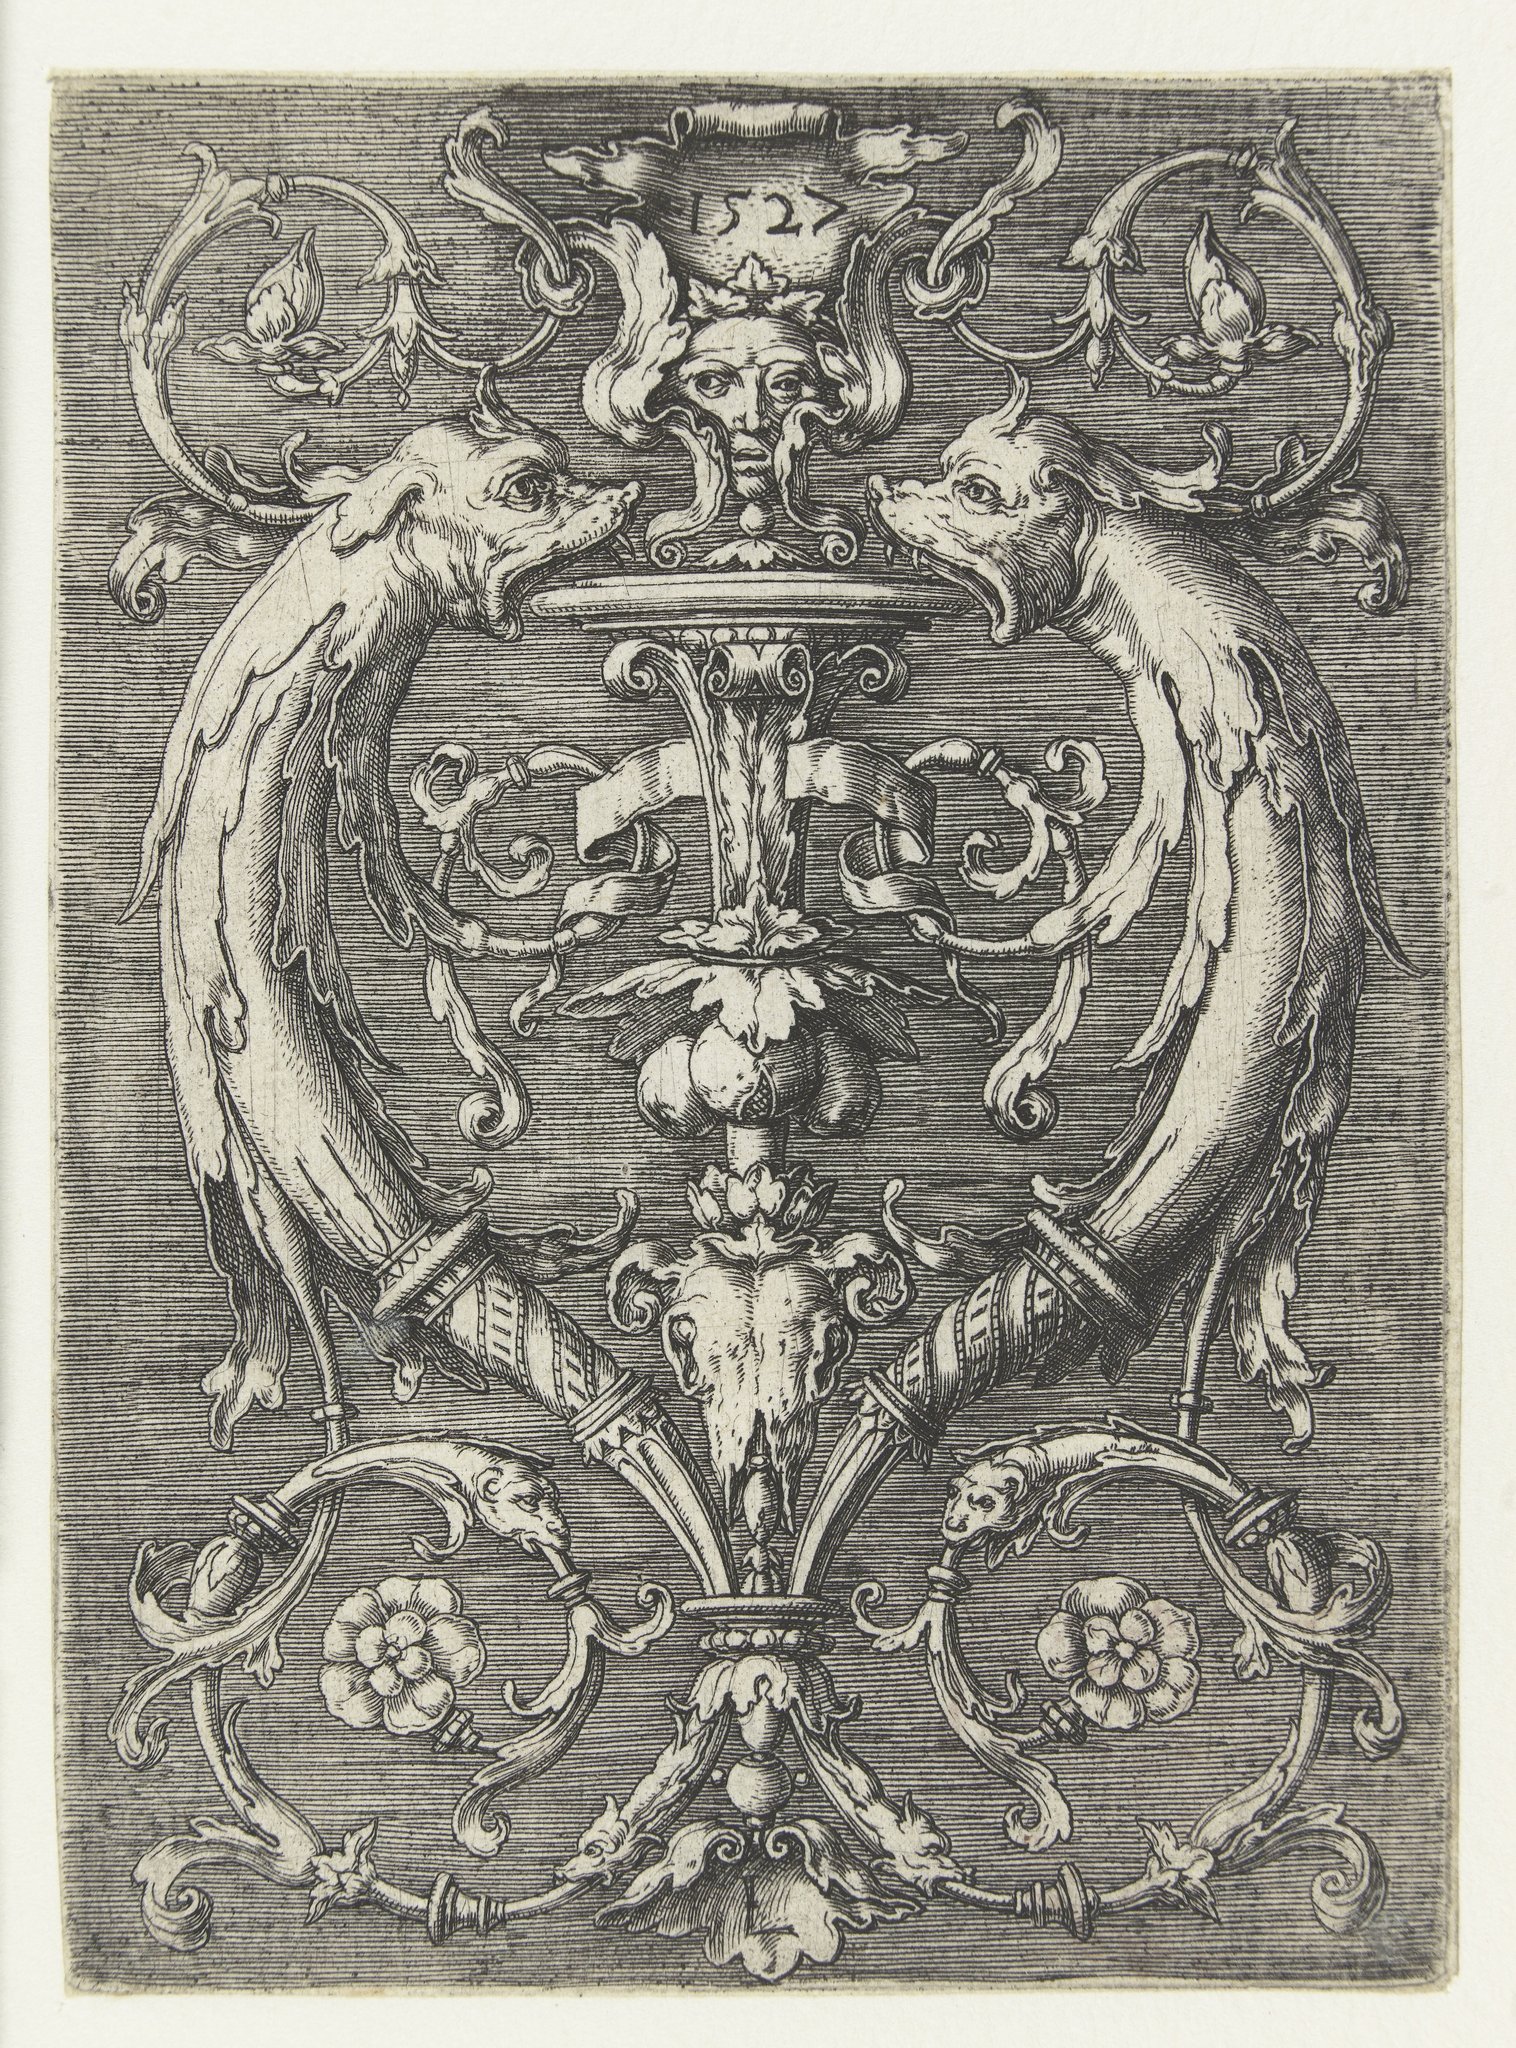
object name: ornament print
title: Ornament met twee dolfijnen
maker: lucas van leyden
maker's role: draughtsman, painter, print maker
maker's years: 1494-1533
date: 1527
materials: paper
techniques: engraving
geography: low countries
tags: dolphin ~ ornament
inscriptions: collector's mark: Lugt 240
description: Kandelaber met een dierschedel, vruchten en een mascaron tussen twee dolfijnen met voluten van bladranken als staarten, gearceerde achtergrond.